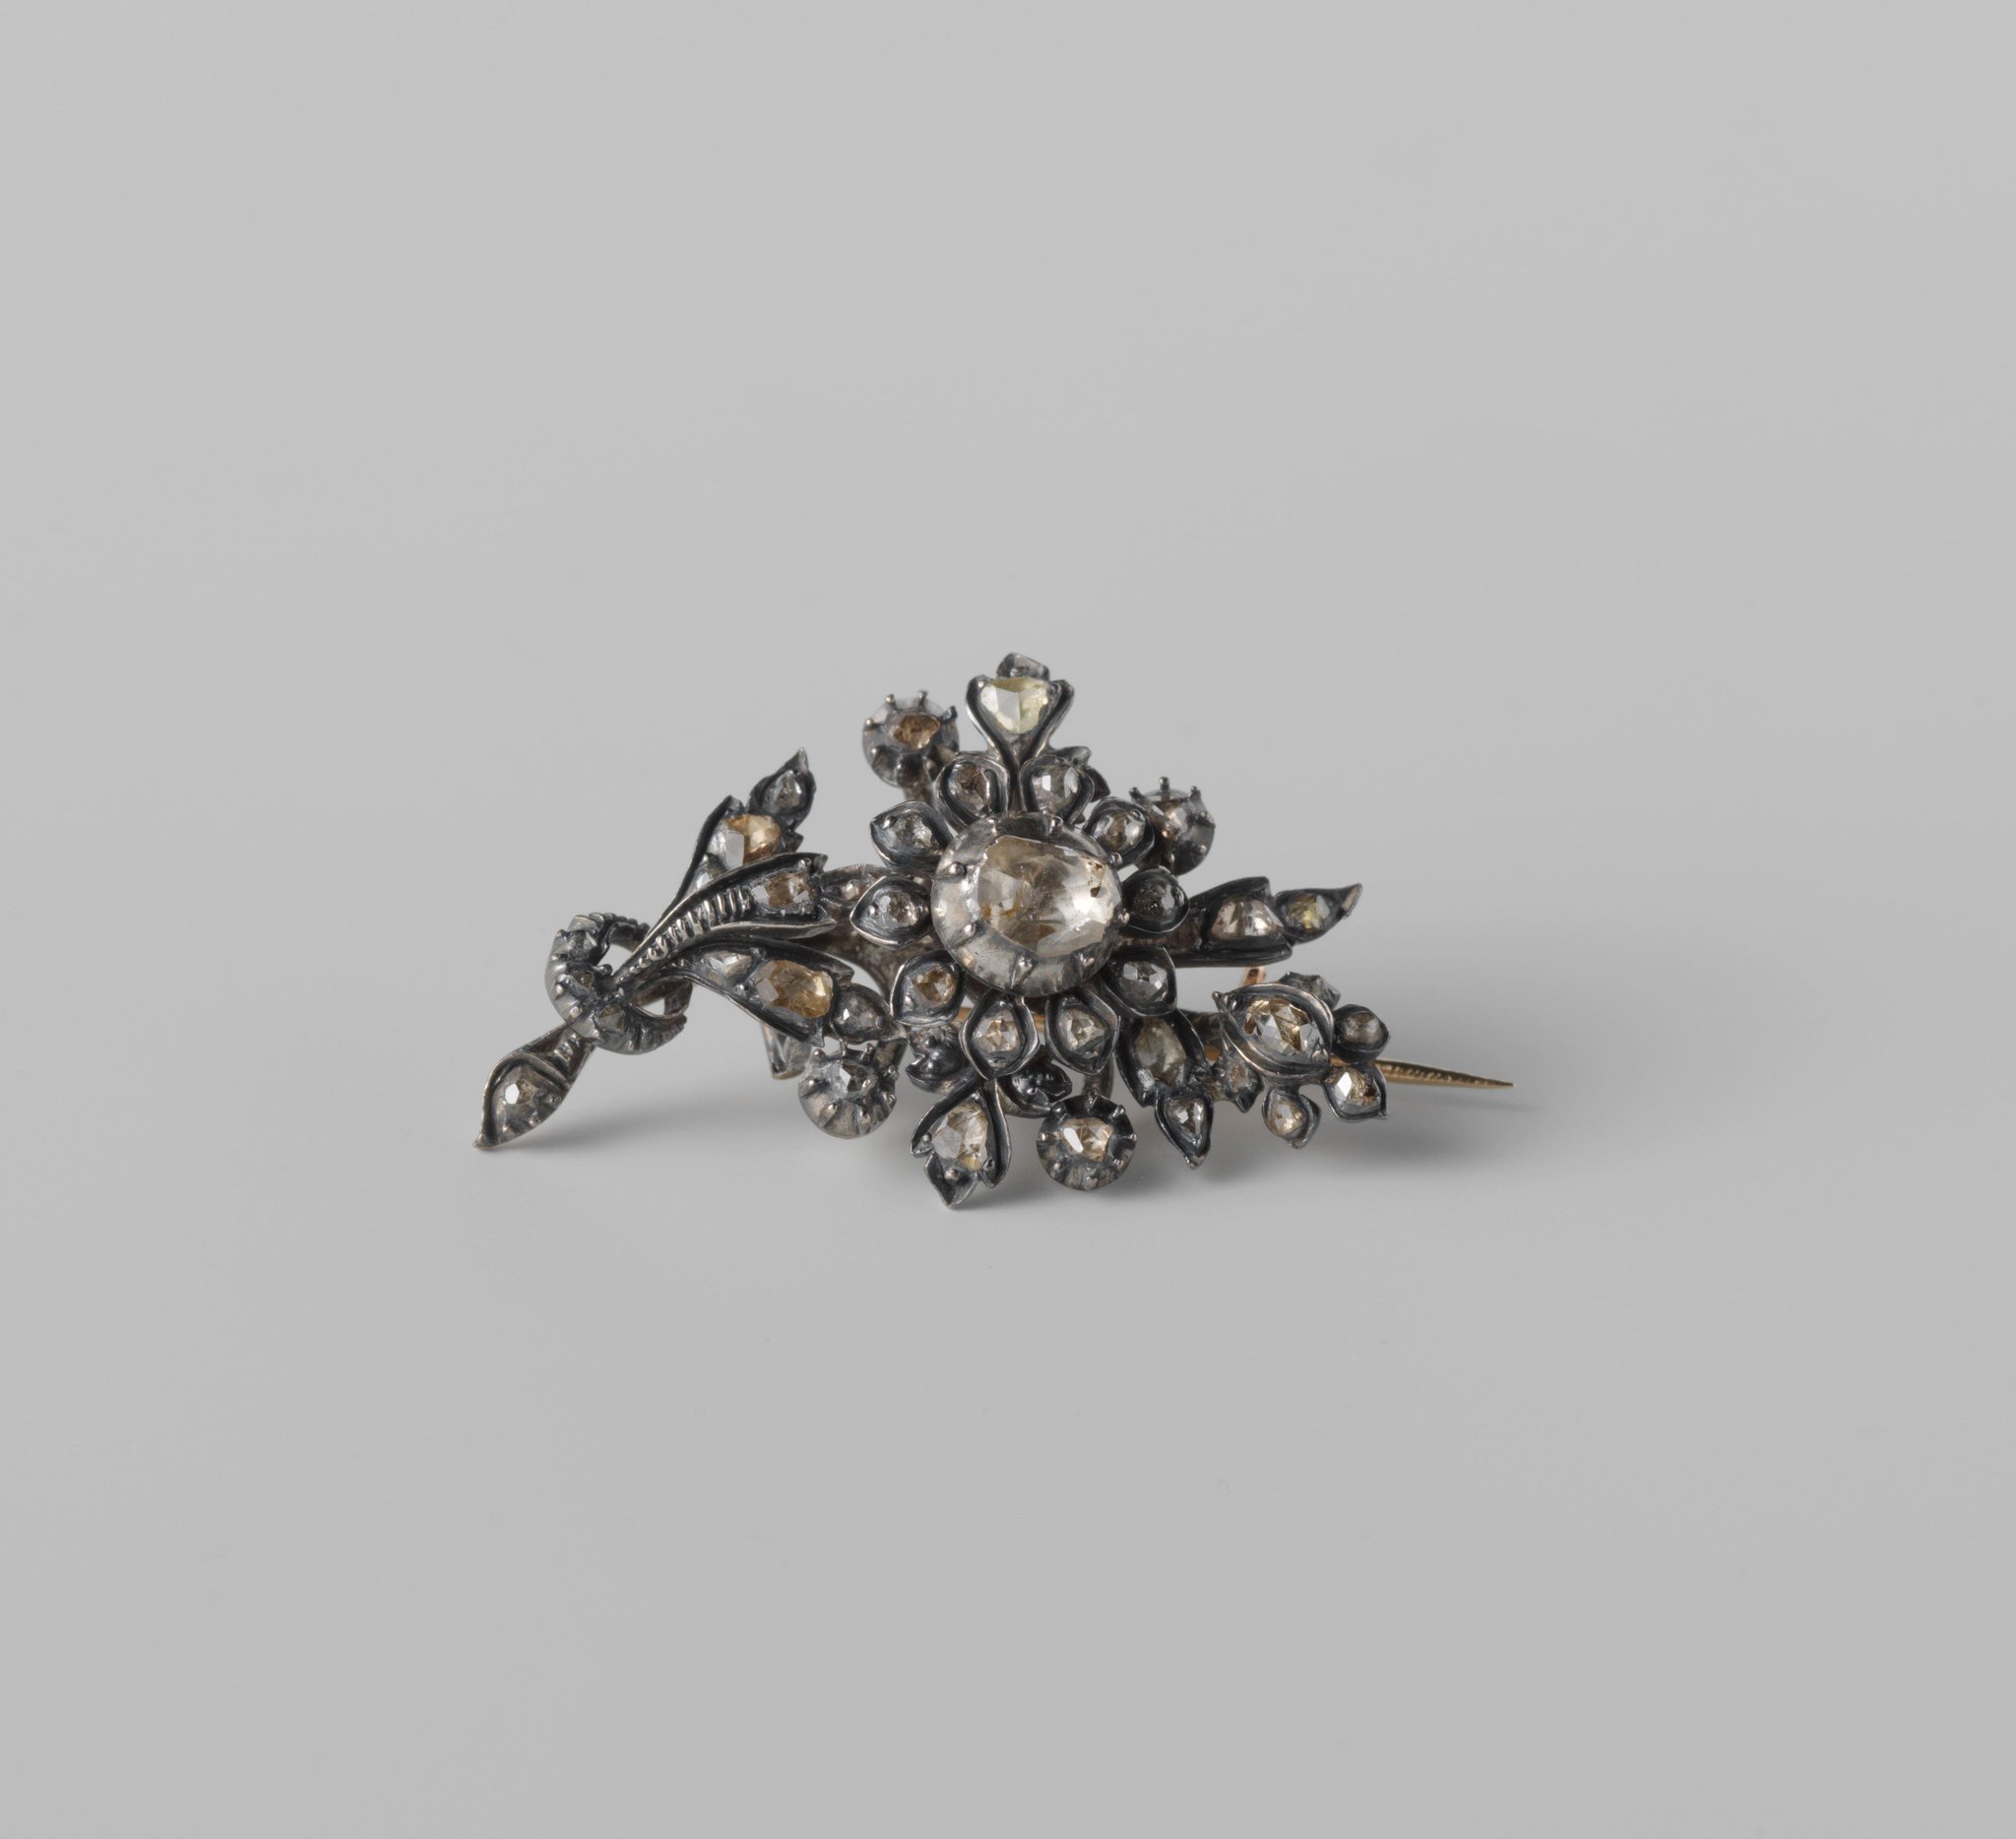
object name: jewellery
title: Broche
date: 1800-1900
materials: silver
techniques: gilding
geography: zeeland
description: Een broche in de vorm van een tak met bloem van imitatie diamanten in een verguld zilveren zetting. In het midden een rozet, waarin een als brillant geslepen steen.